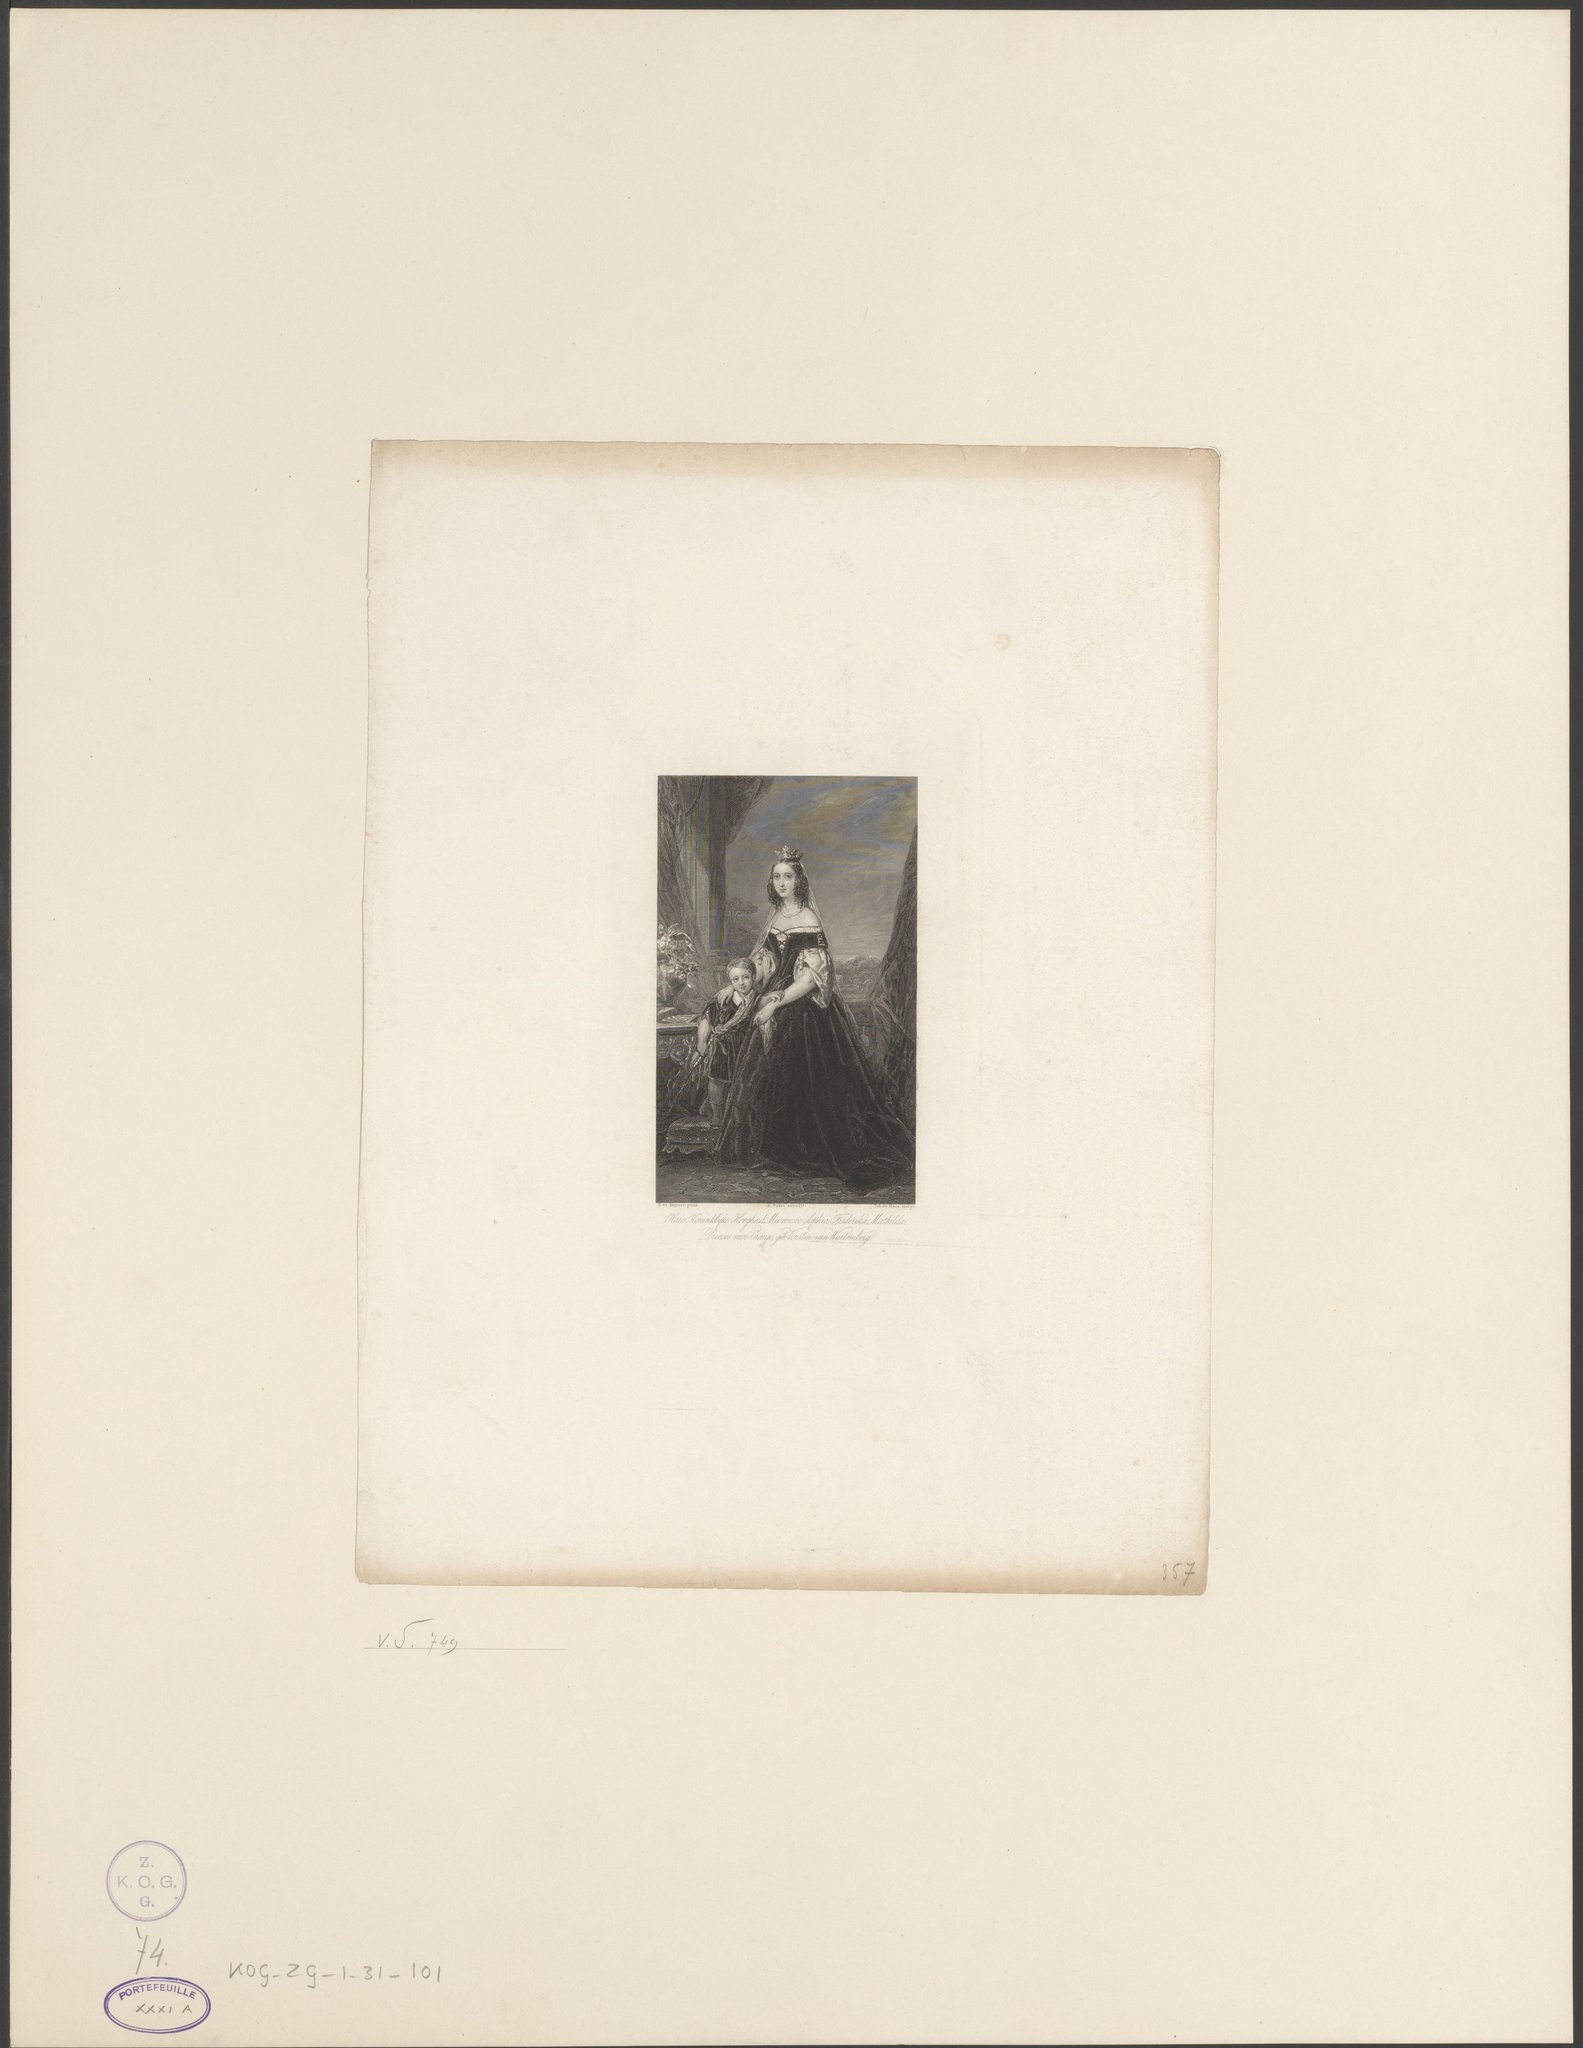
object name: print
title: Hare Koninklijke Hoogheid Mevrouw Sophia Frederika Mathilda, Prinses van Oranje, geb. Vorstin van Württemberg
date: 1837-1856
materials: paper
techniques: engraving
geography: the hague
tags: paris, willem (prins der nederlanden), the hague, sophia frederika mathilda van württemberg, historical persons - bb - woman, historical persons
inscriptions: stamp, collector's mark: Lugt 1641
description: Onderwerpsrubrieken binnen de Atlas Zeden en Gewoonten: Portretten, Portretten van Vorsten uit het huis van Oranje, Regeerende Vorsten, Koningen uit het huis van Oranje.